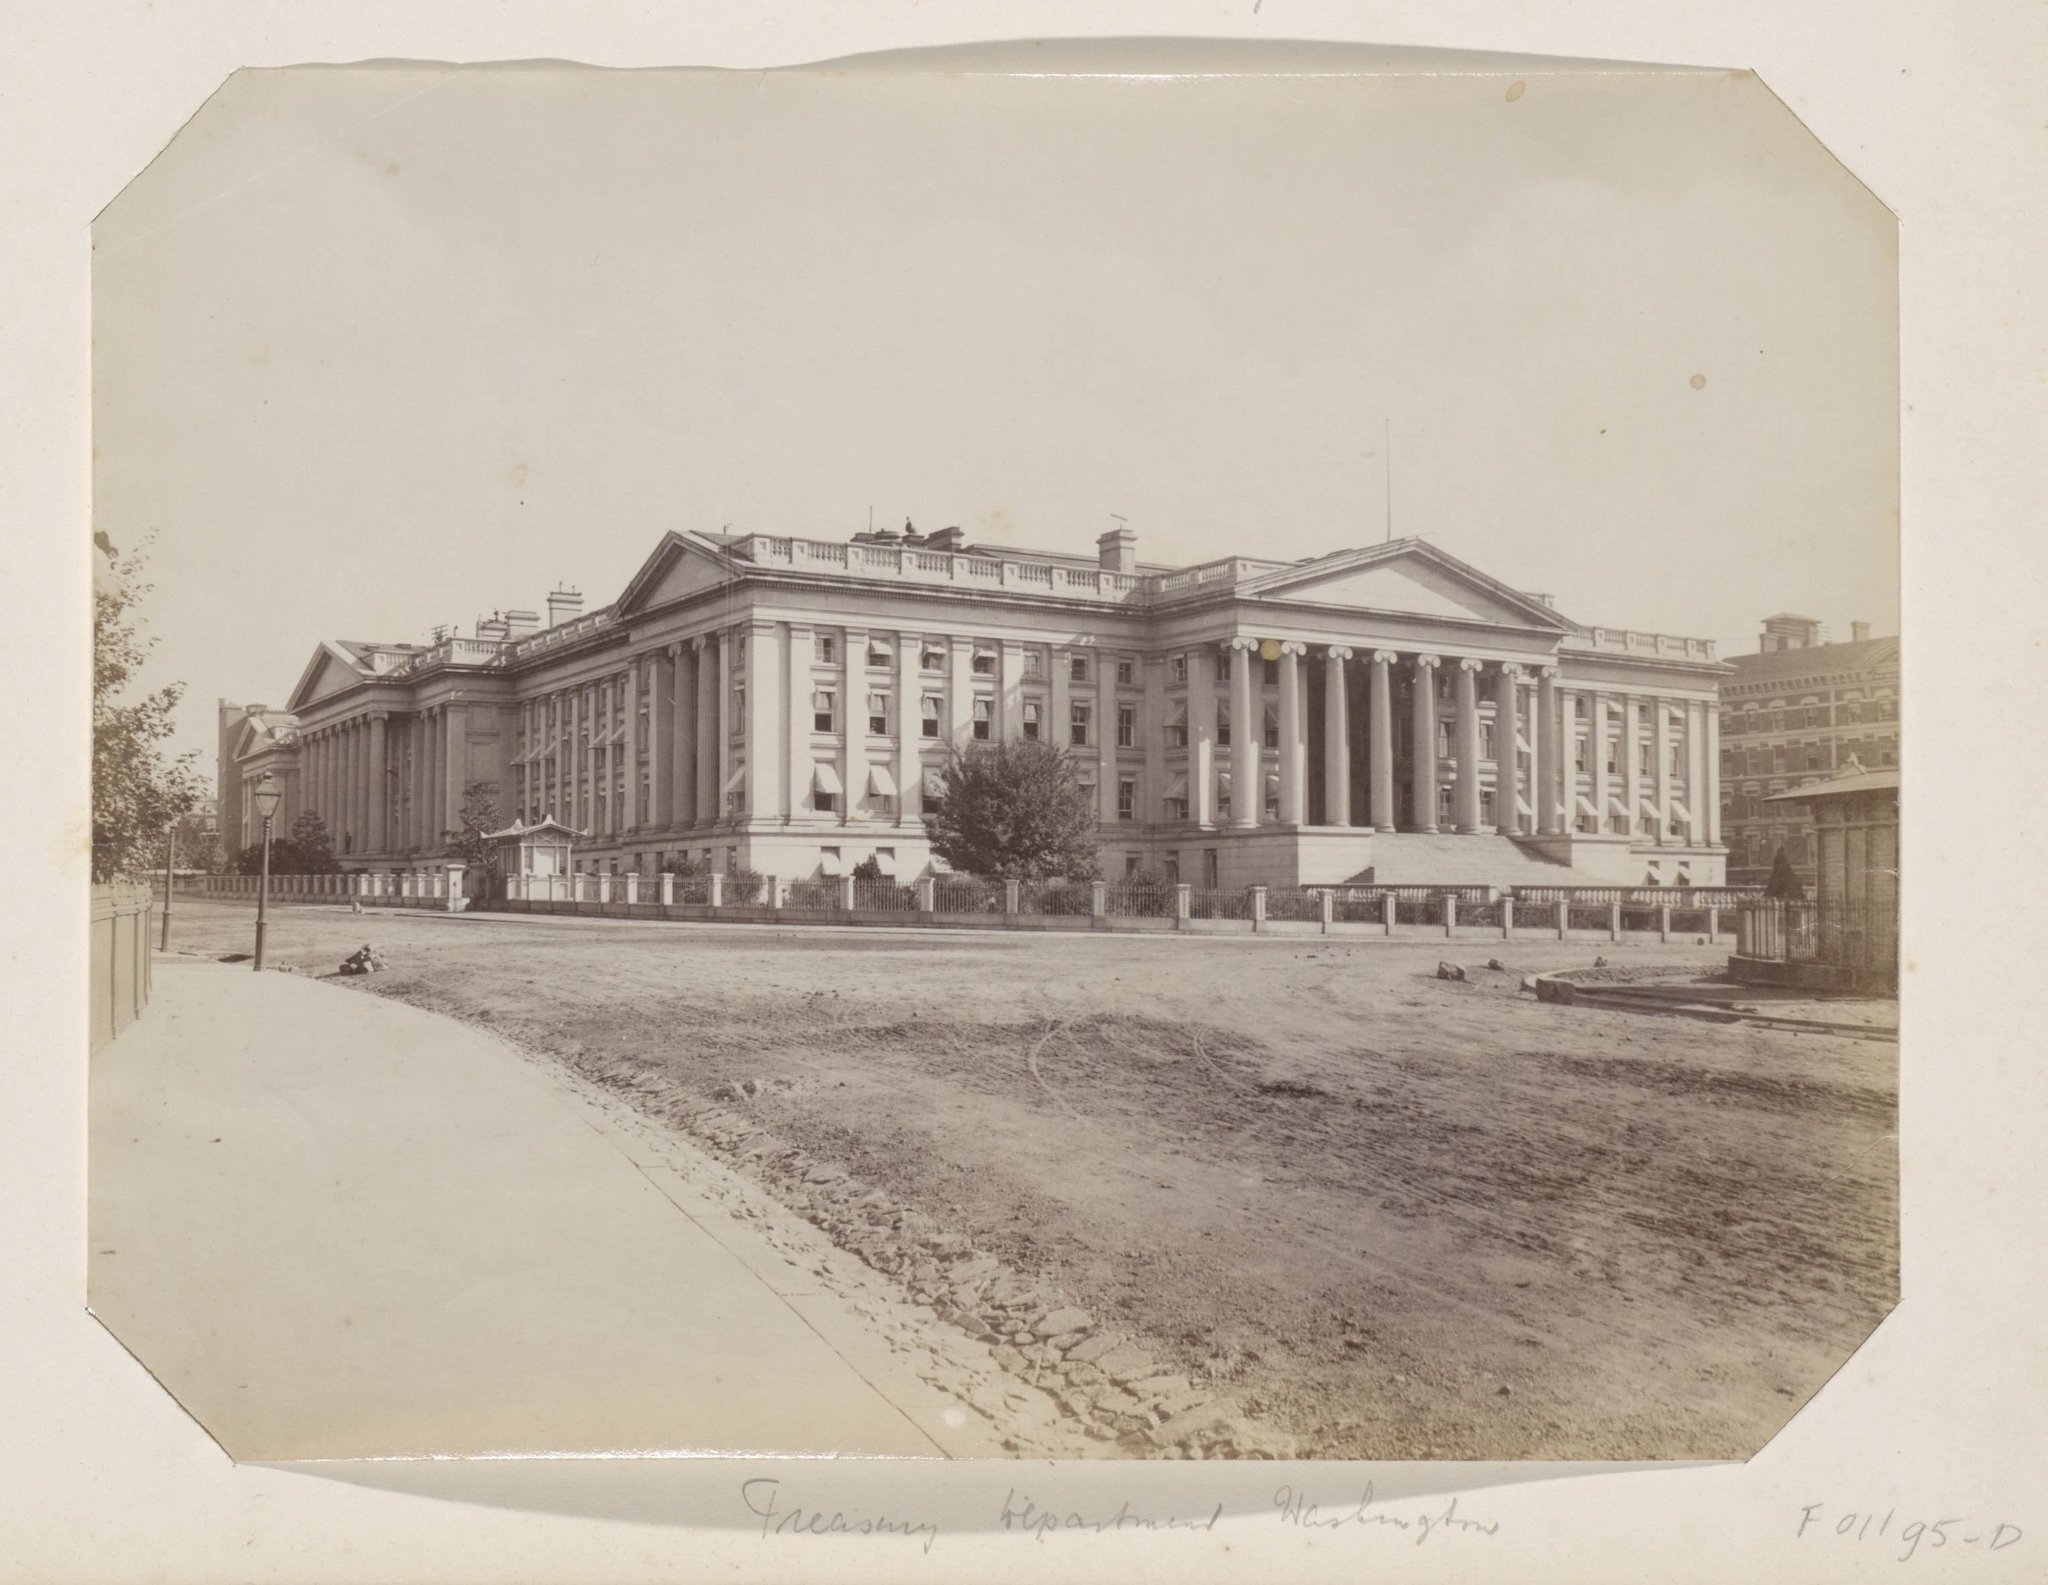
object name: photograph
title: Exterieur van het Amerikaans ministerie van Financiën in Washington D.C.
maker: Anonymous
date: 1860-1900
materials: cardboard, paper, photographic support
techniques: albumen print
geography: washington d.c.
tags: washington d.c.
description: Onderdeel van Fotoalbum van een reis door de Verenigde Staten, Honolulu, Nederlands-Indië, Aden, Zanzibar en Zuidelijk Afrika.